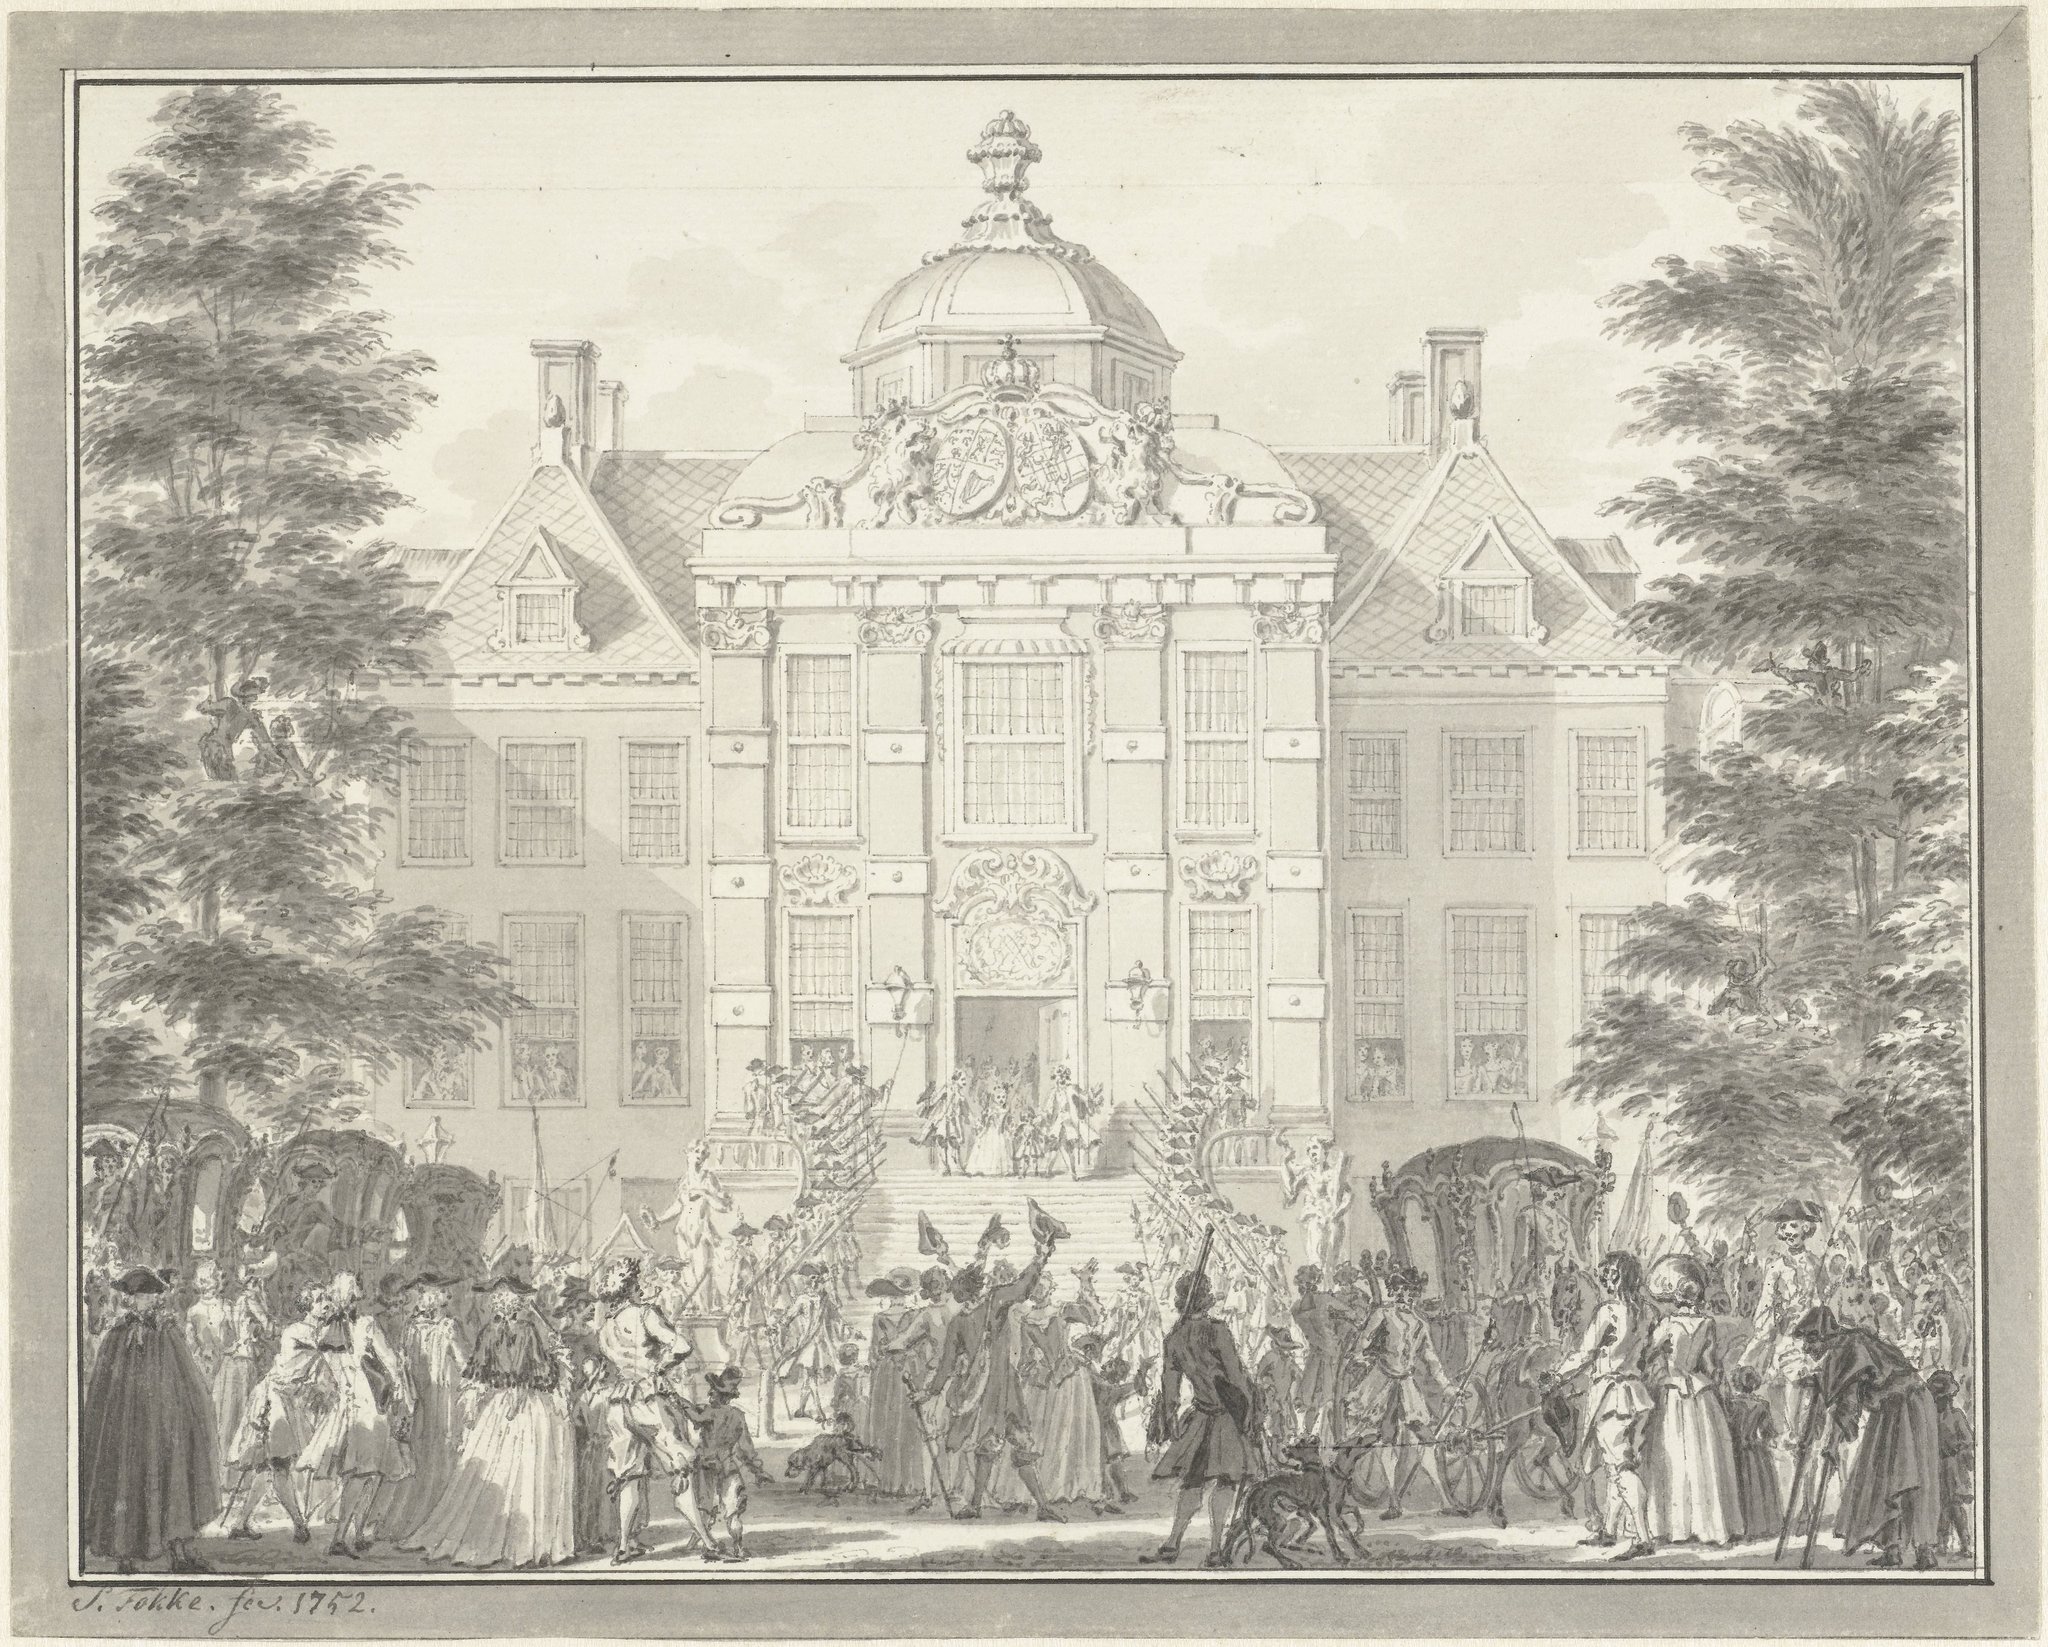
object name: drawing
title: Willem V vertoont zich als Ridder in de Orde van de Kousenband op het bordes van Huis ten Bosch, 1752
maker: simon fokke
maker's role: draughtsman, print maker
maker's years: 1712-1784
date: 1752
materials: paper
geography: northern netherlands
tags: the hague, william v (prince of orange), knighthood order (garter)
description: De jonge prins Willem V vertoont zich na zijn installatie als Ridder in de Orde van de Kousenband op het bordes van Paleis Huis Ten Bosch, 5 juni 1752. Op de straat voor het paleis wordt hij toegejuichd door een verzameld menigte. Ontwerp voor een prent.